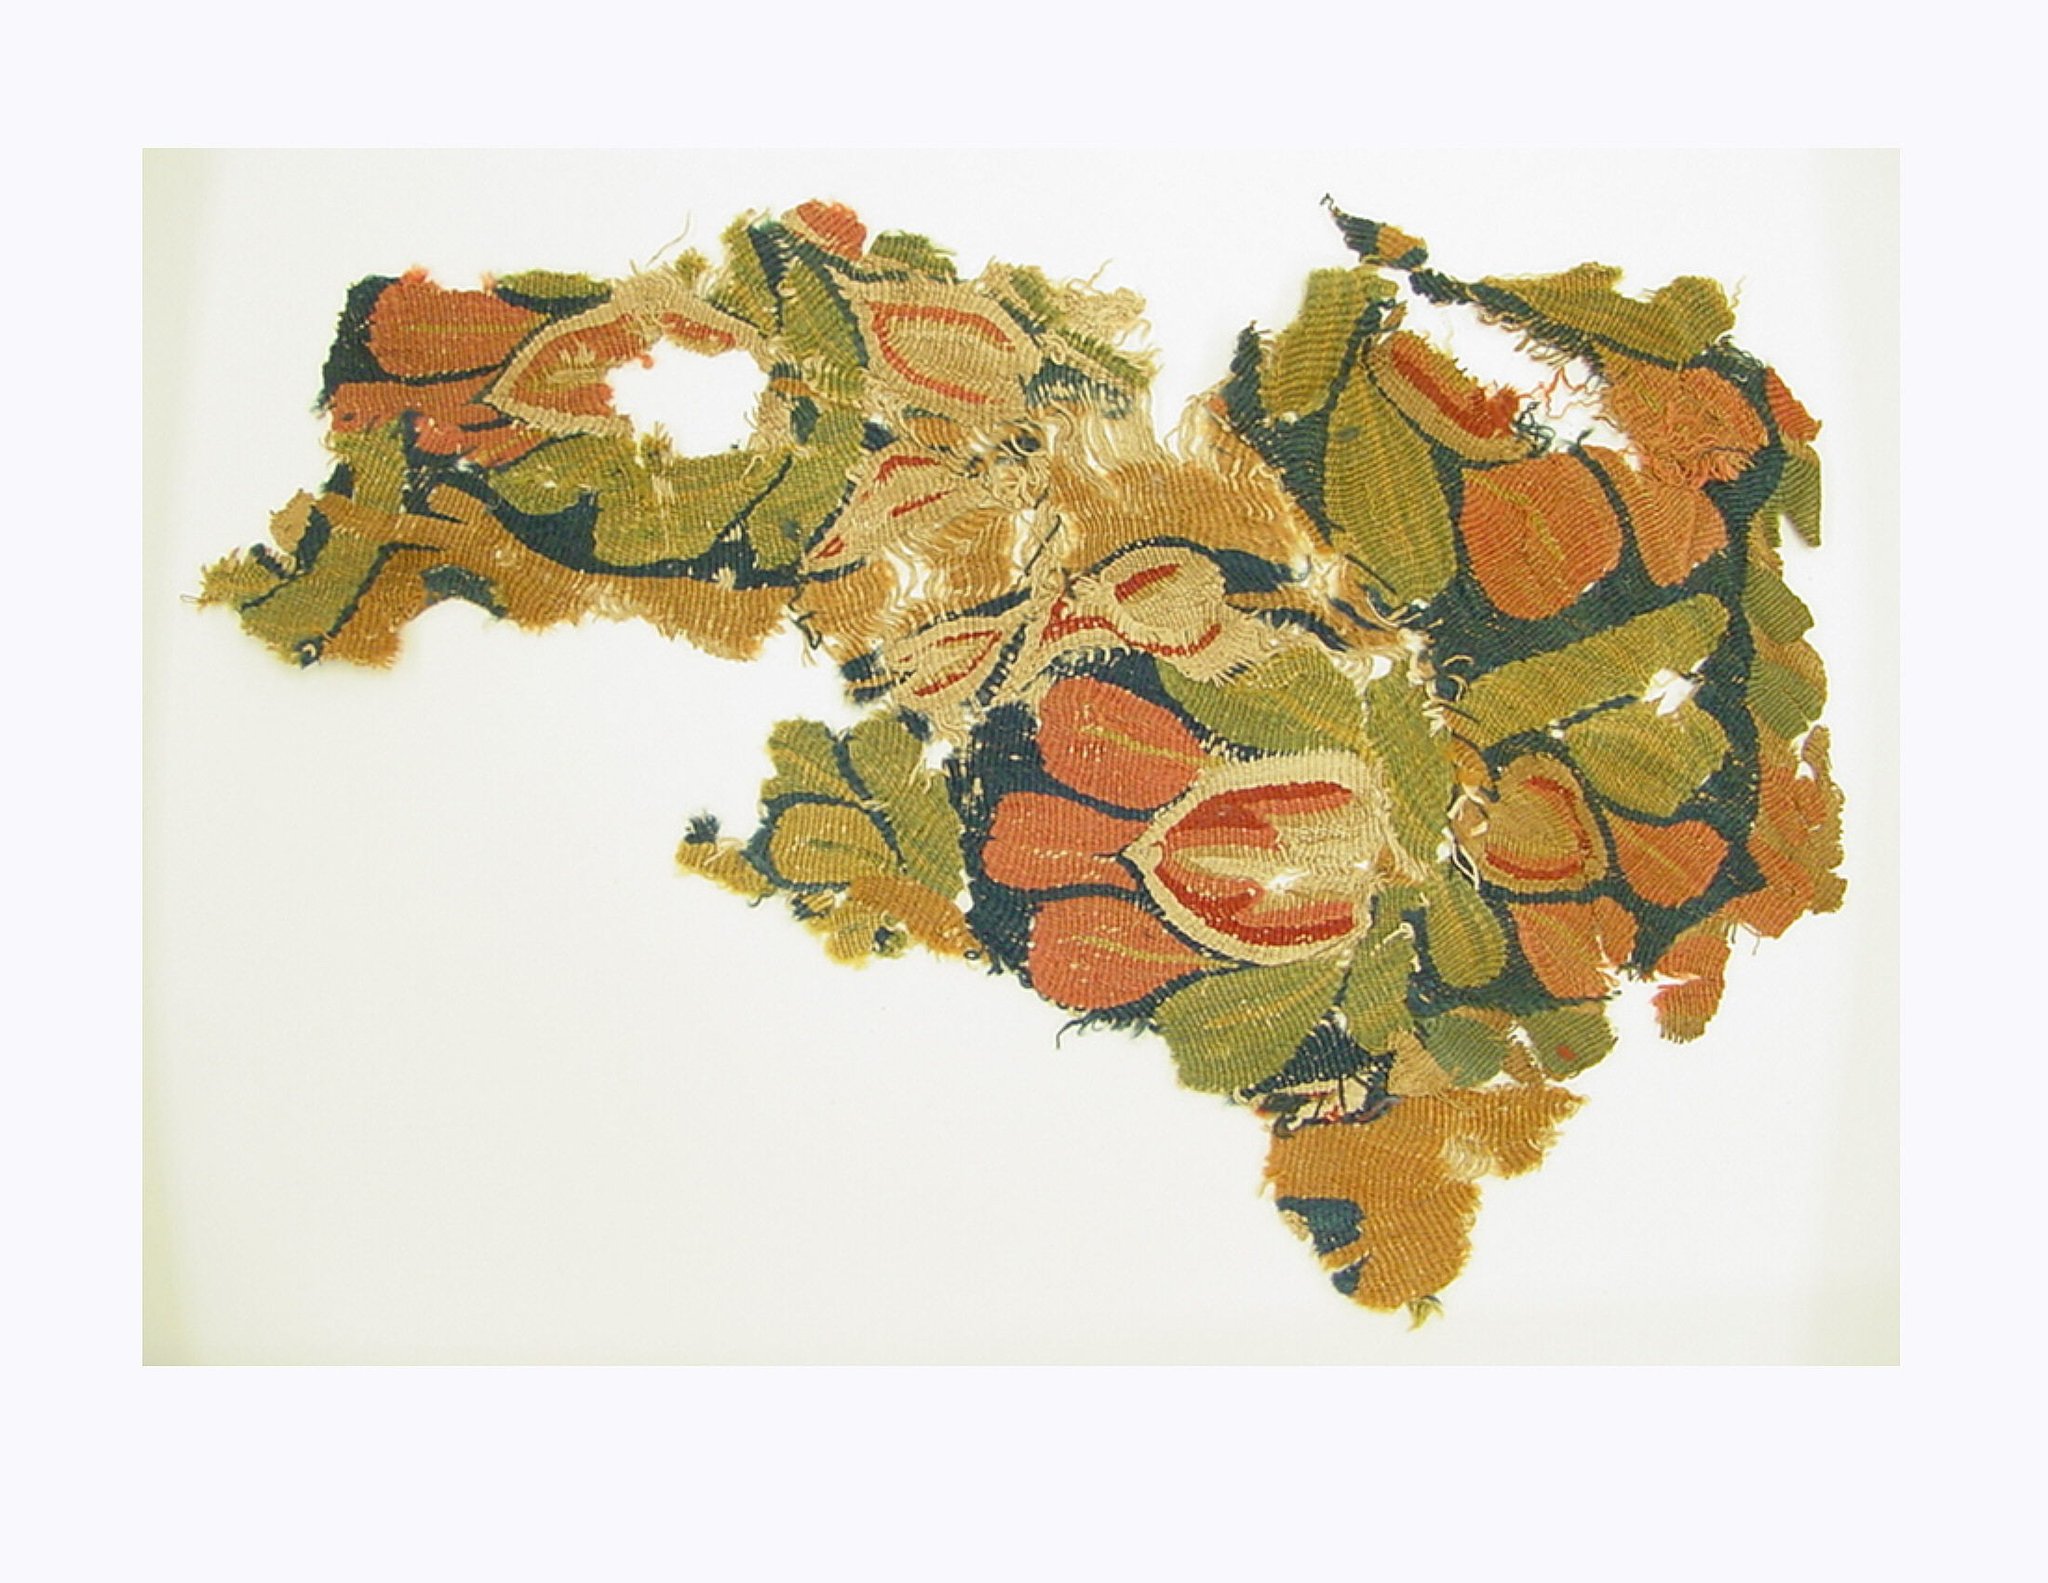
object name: textile fragment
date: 301-500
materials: linen, wool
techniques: weave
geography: egypt